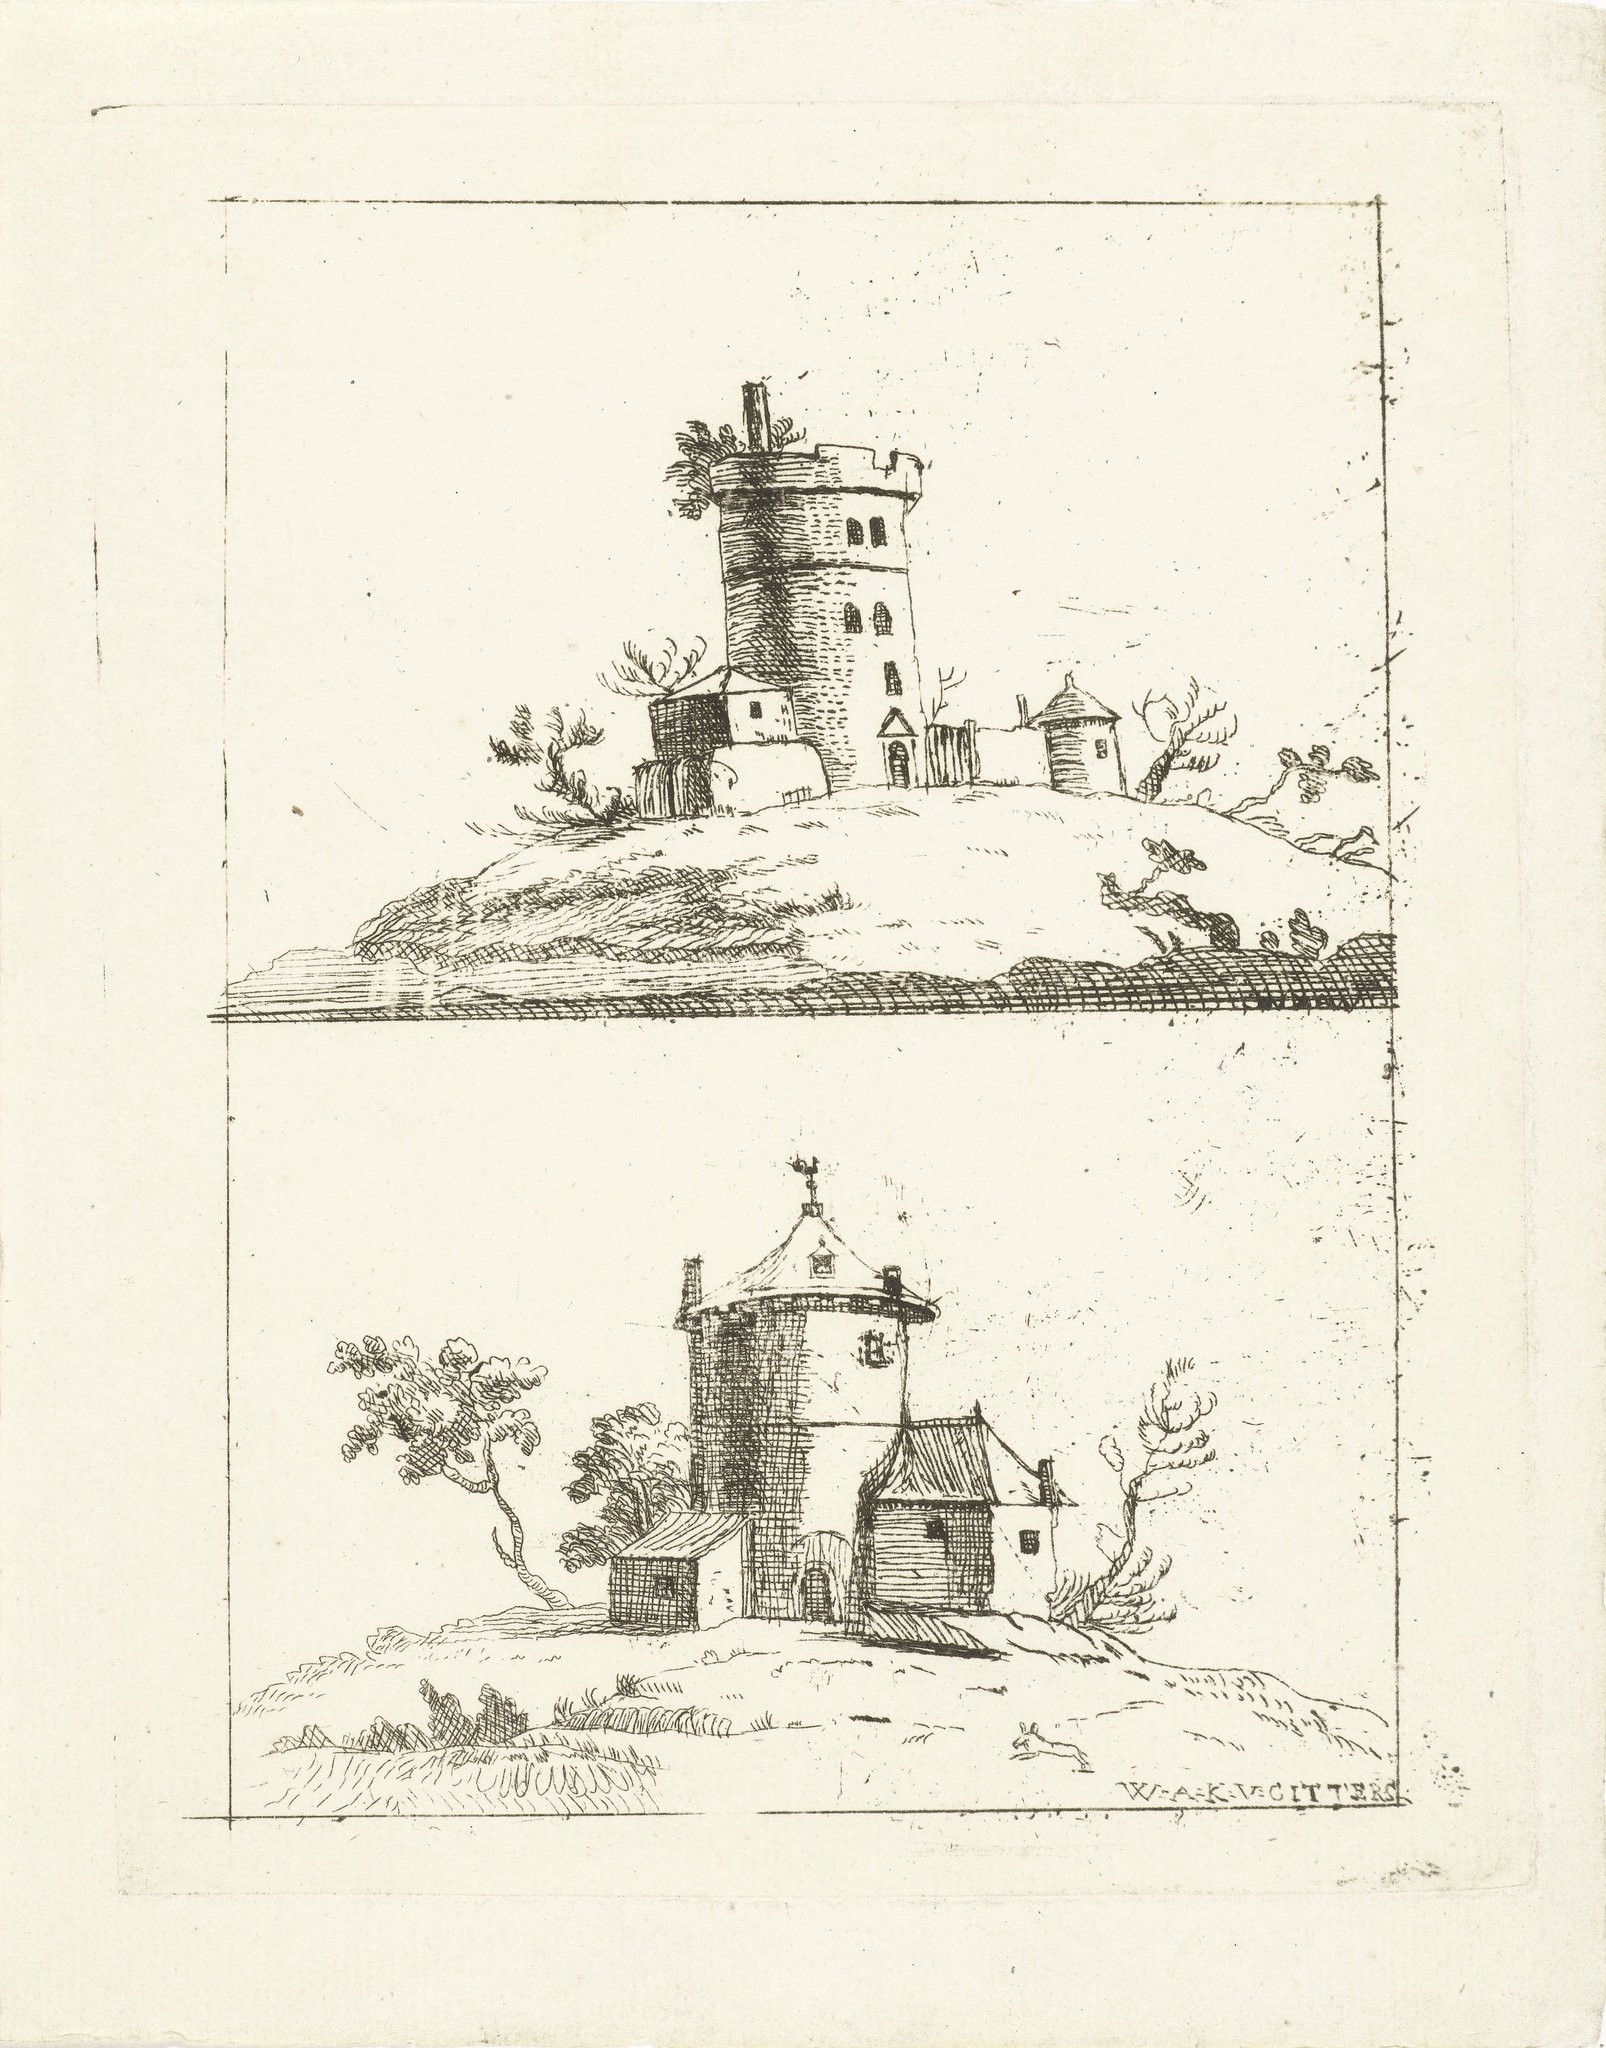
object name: print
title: Twee ronde torens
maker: willem aarnoud kien van citters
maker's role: mayor, print maker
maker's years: 1756-1794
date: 1770-1794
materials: paper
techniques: etching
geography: middelburg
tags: weathercock, landscape with tower or castle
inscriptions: collector's mark: Lugt 2228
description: Blad met twee voorstellingen. Boven een ronde toren met bijgebouwen, onder een toren met dak met windhaan en bijgebouwen.